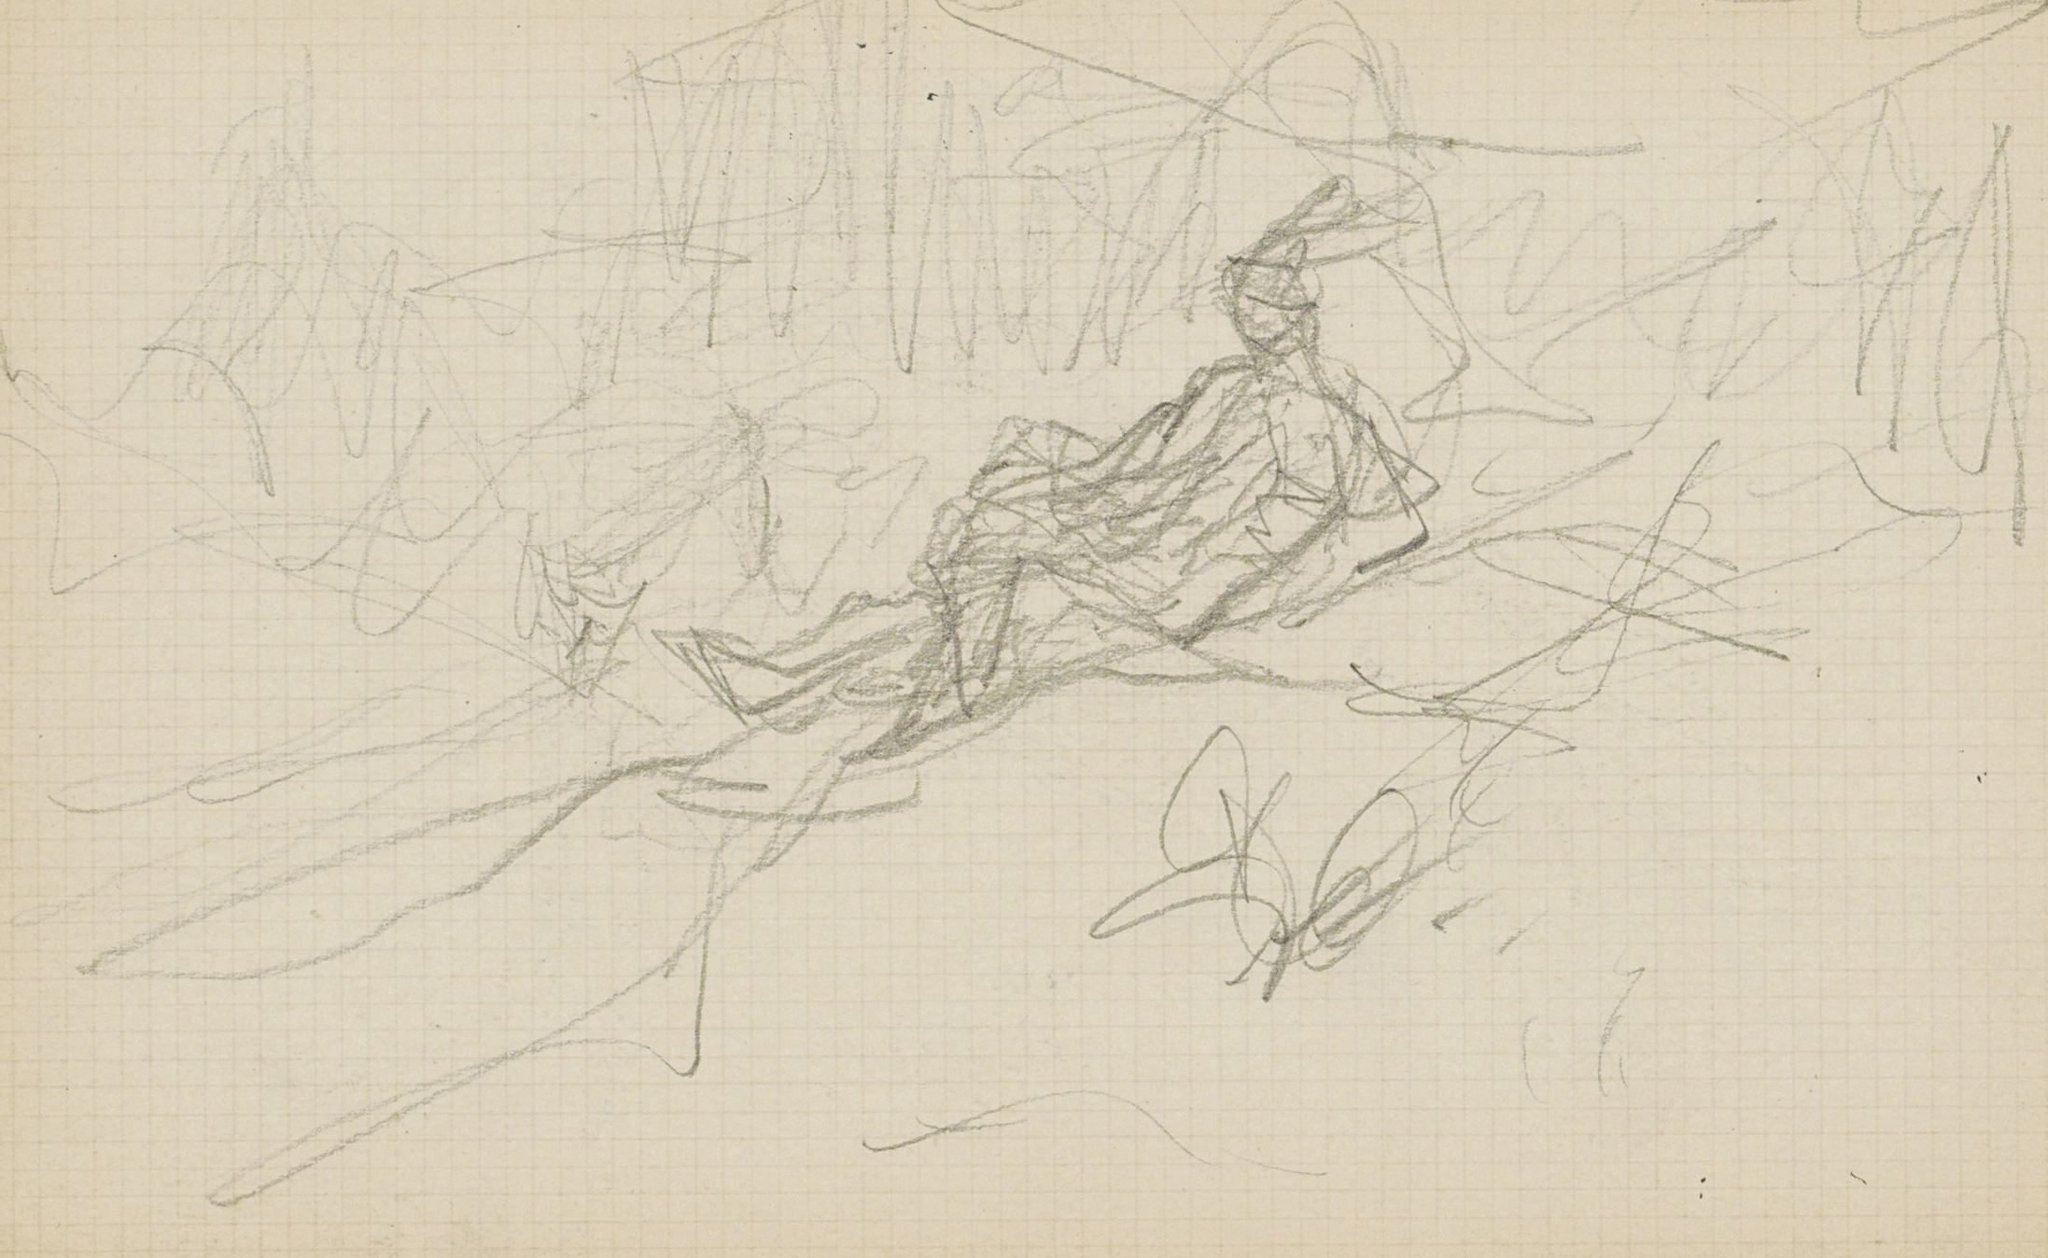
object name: sketchbook leaf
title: Landschap met een liggende figuur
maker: matthijs maris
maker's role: draughtsman, painter, print maker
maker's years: 1839-1917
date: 1849-1917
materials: pencil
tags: lying figure, landscapes (+ landscape with figures, staffage)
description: Blad 23 verso uit een schetsboek met 35 bladen.